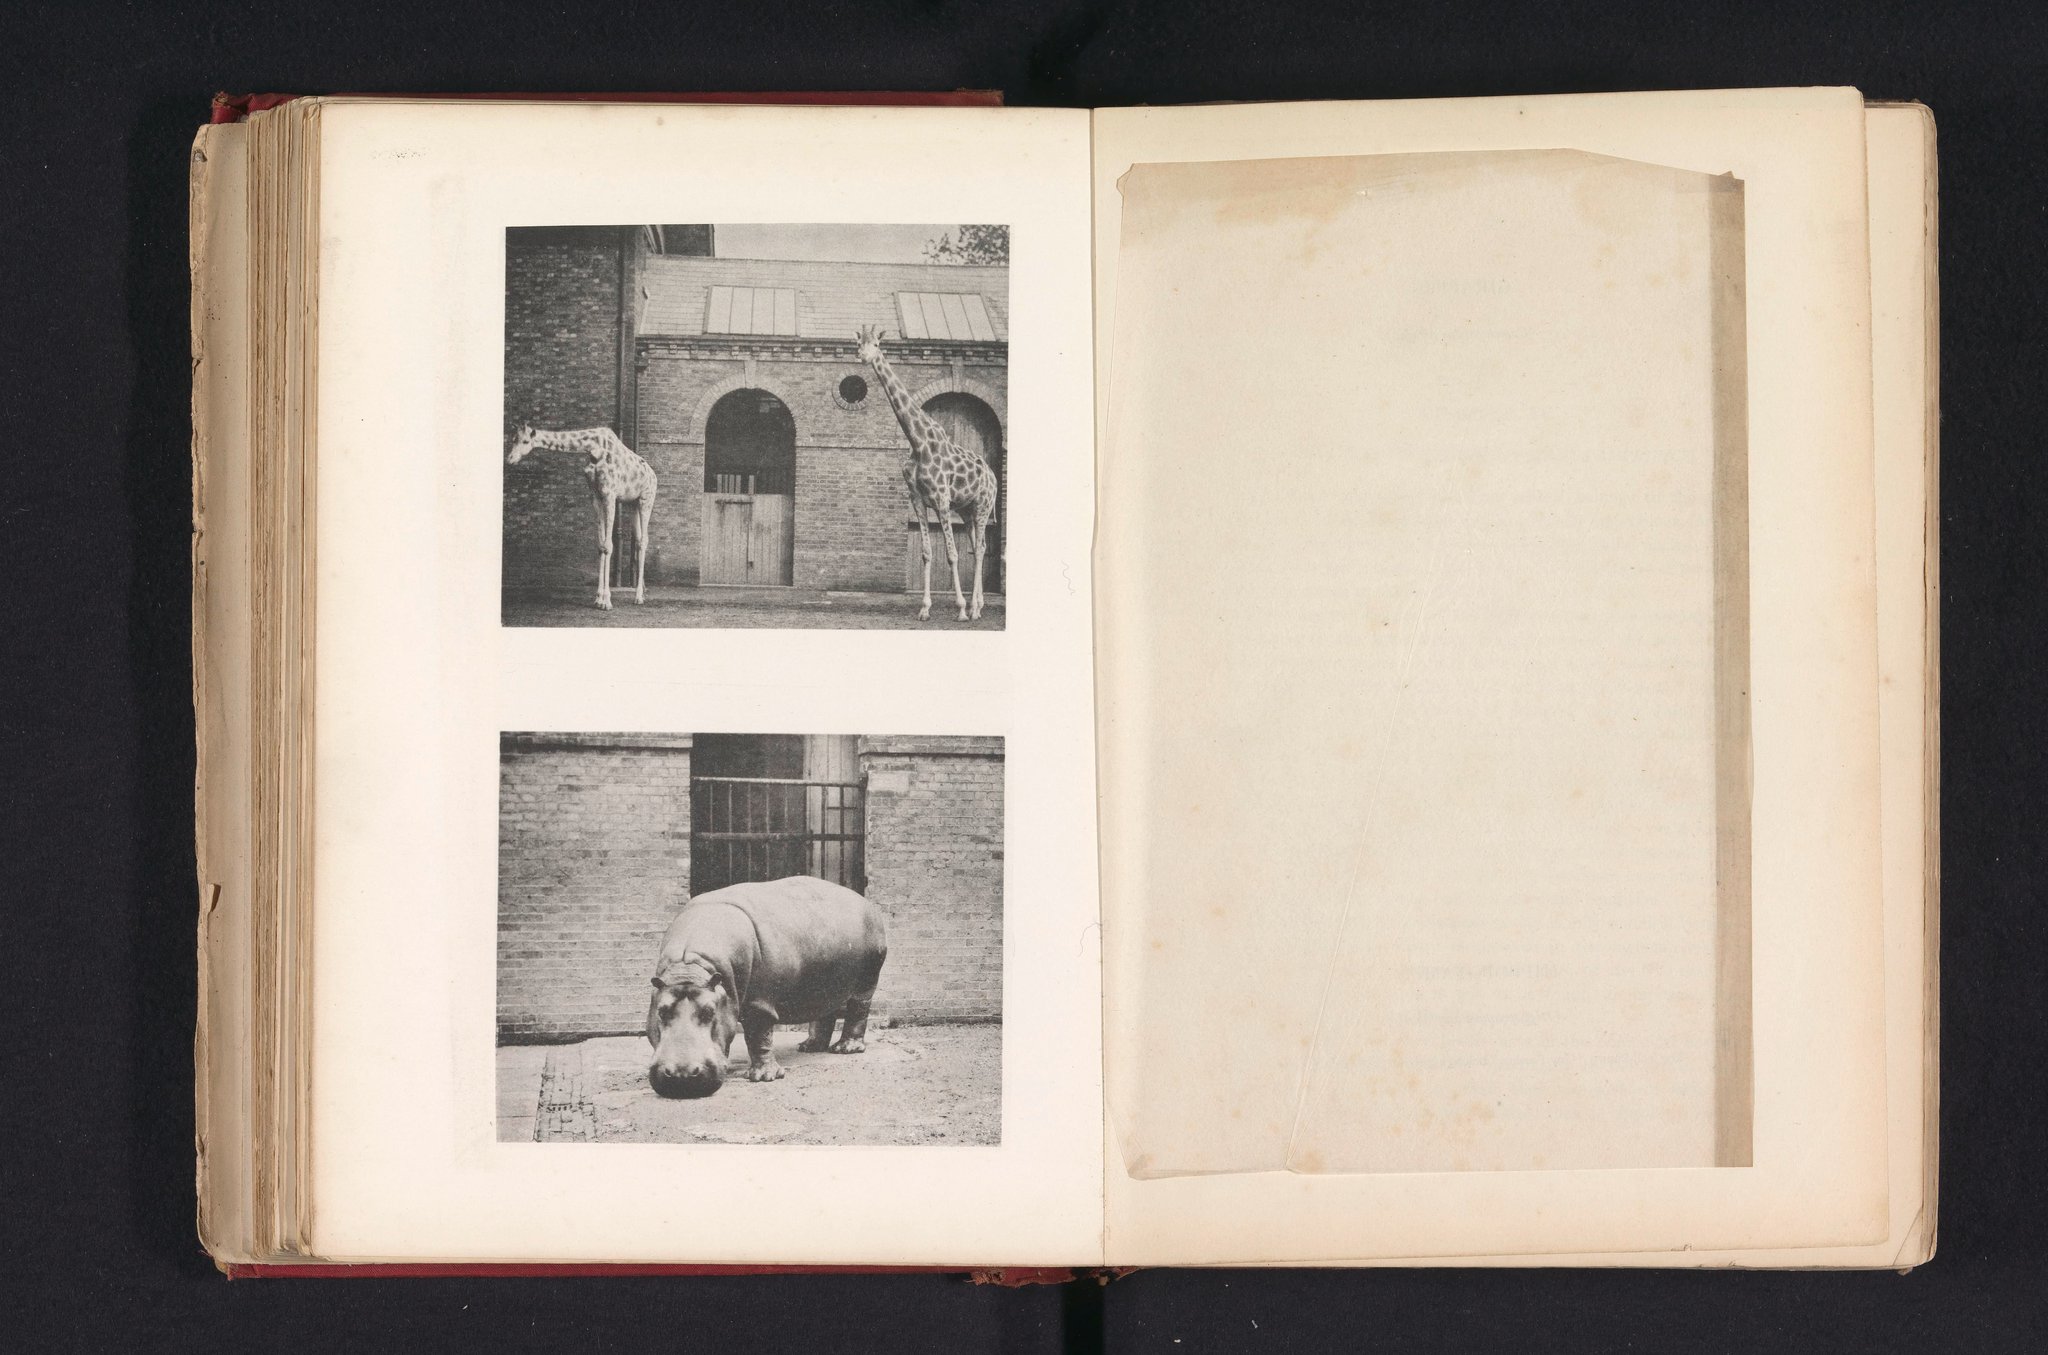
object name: page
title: Giraffes, hippopotamus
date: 1876-1886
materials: paper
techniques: photograph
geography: london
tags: hoofed animals: hippopotamus, zoological garden, zoo, seen as place where non-domestic animals are kept, hoofed animals: giraffe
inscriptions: inscription: ‘The Well-known "Guy Fawkes" belonging to the Zoological Society.’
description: Boven twee giraffen, onder een nijlpaard, allen in een dierentuin.